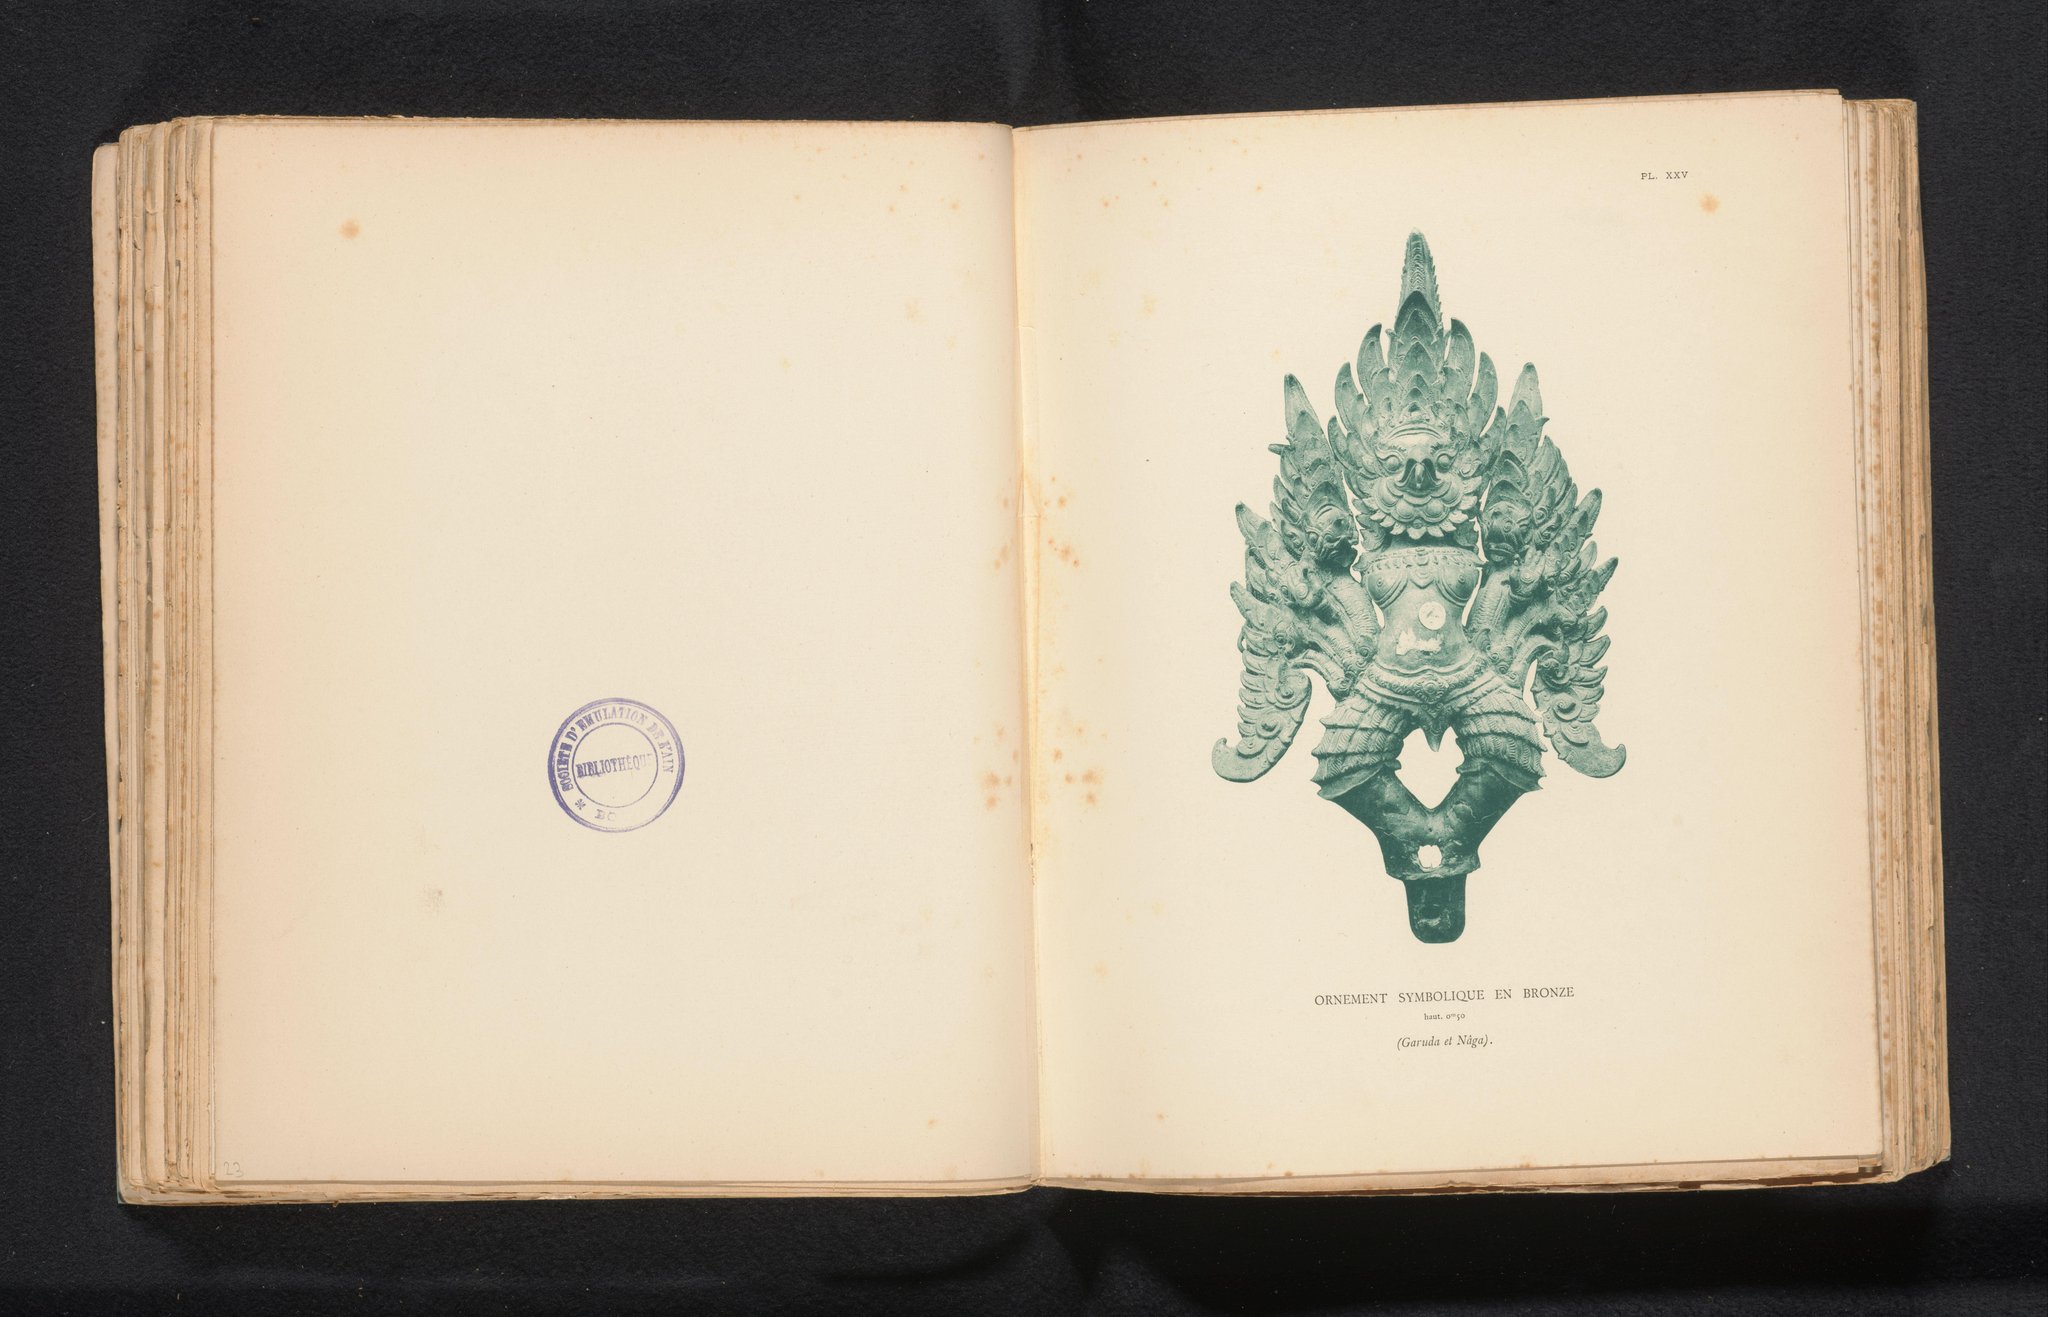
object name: photomechanical print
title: Ornement symbolique en bronze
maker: Anonymous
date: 1890-1895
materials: paper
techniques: photograph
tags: hinduism, buddhism, jainism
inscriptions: inscription: ‘haut 0.50/ (Garuda et Nâga)’, collector's mark: ‘Société d'Emulation de l'Ain/ Bourg/ Bibliothèque’, inscription: ‘Pl. XXV’